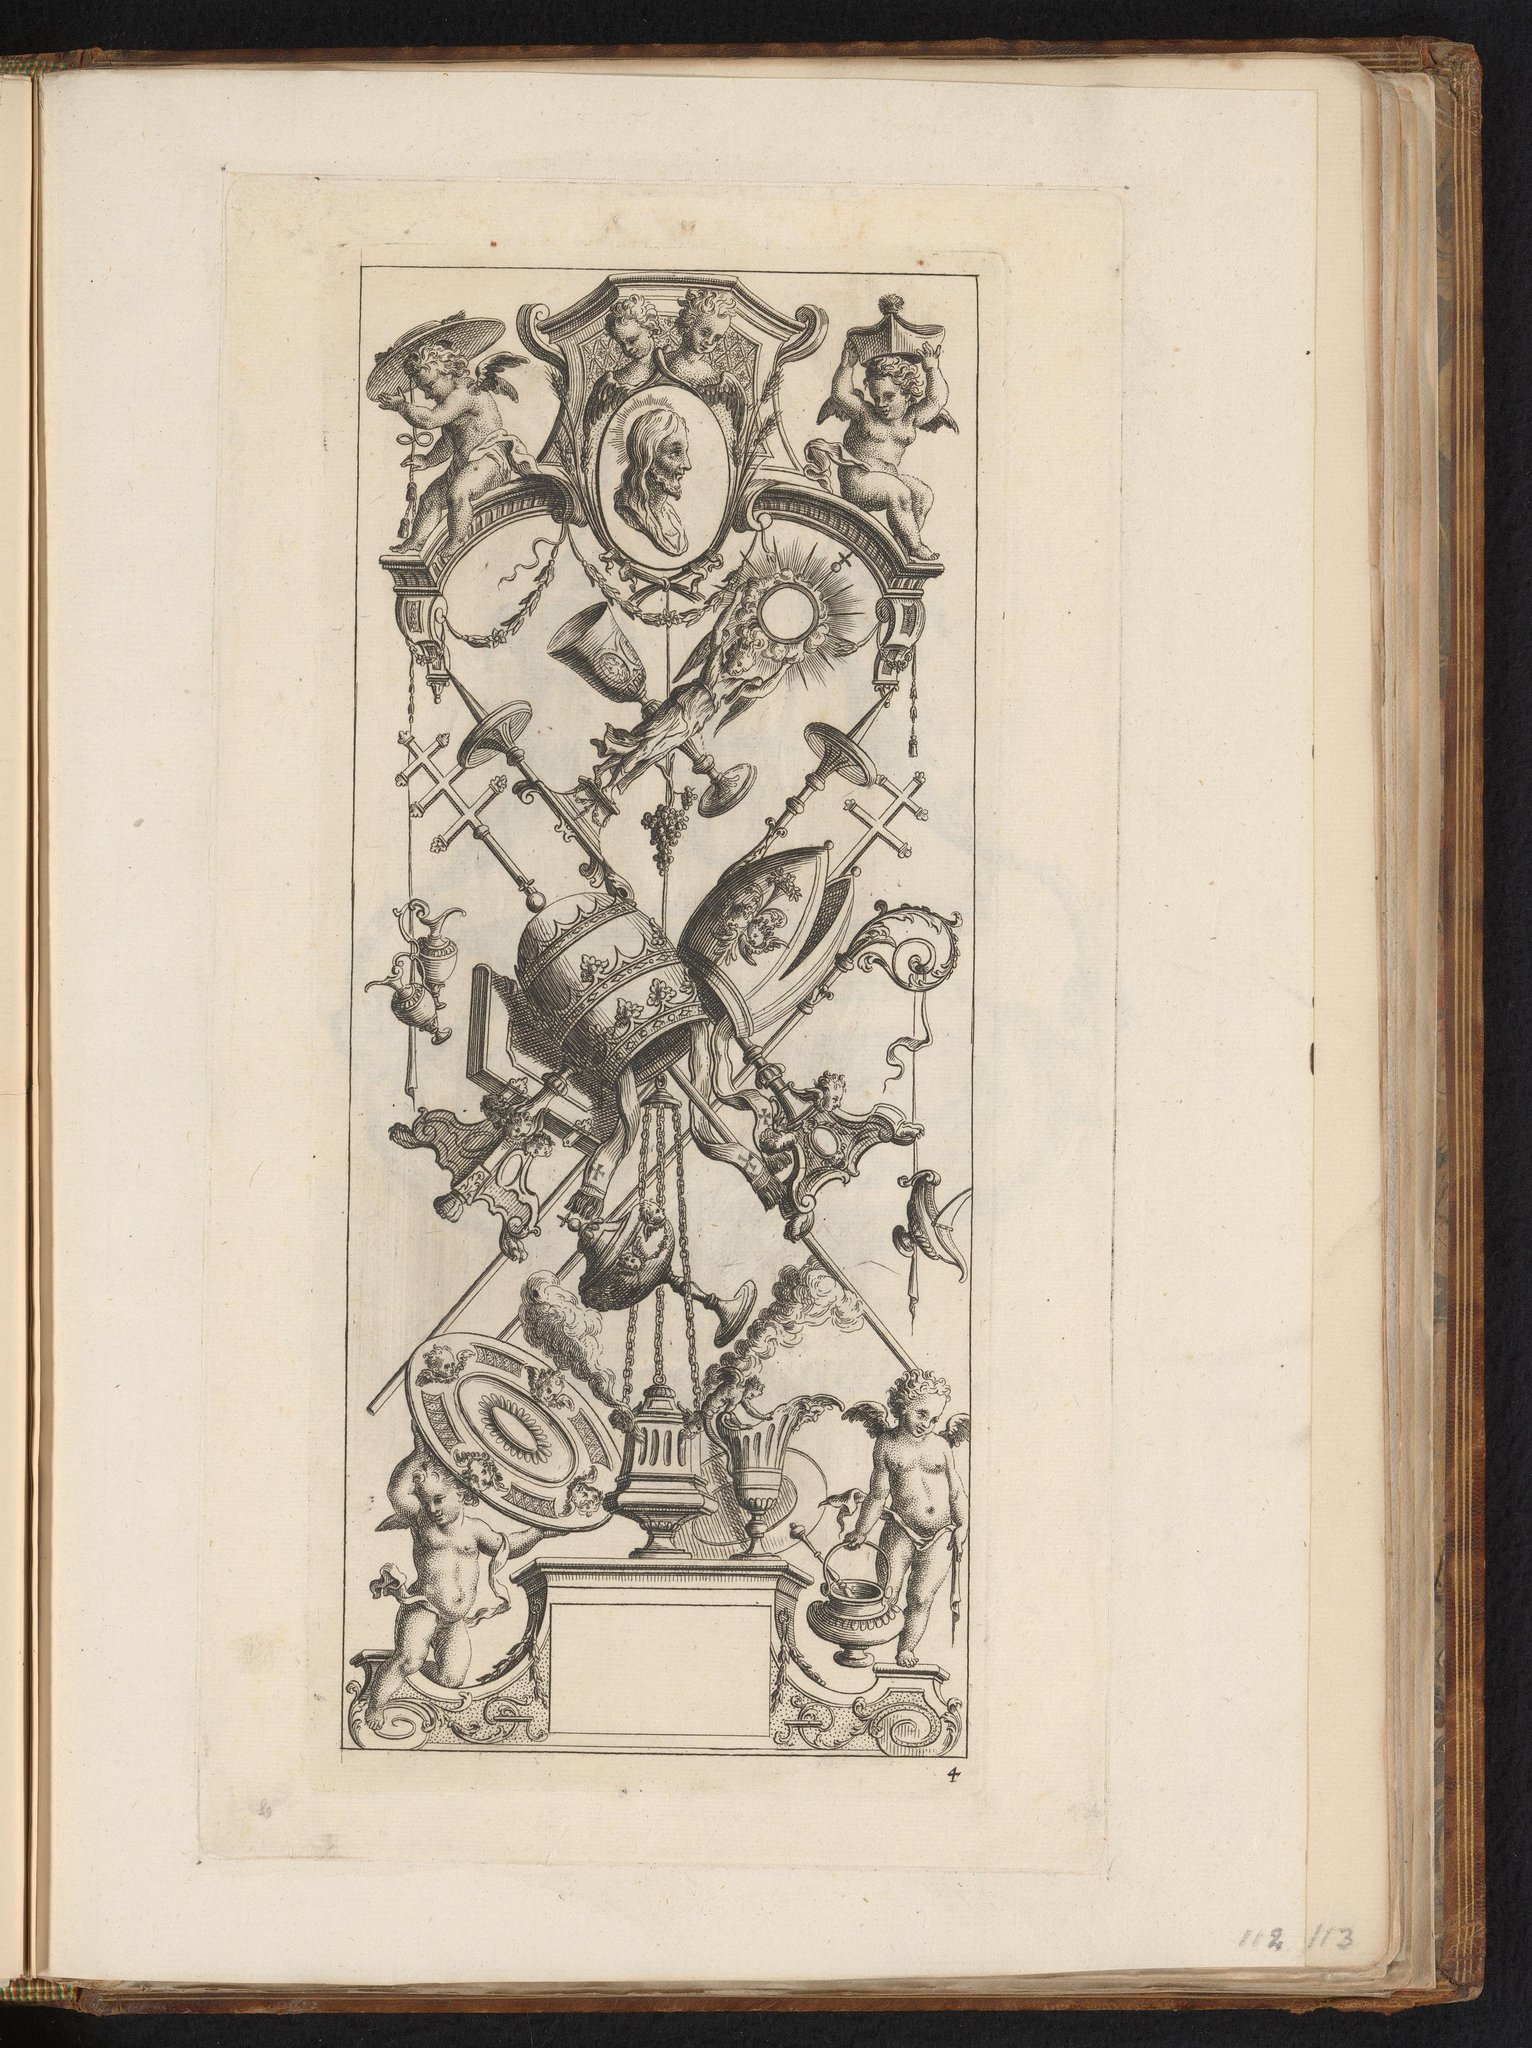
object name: album leaf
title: Livre pour Vaisselle d'Eglise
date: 1700-1735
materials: paper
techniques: etching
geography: nuremberg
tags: (liturgical) equipment of church, trophy, i.e.: decorative arrangement of symbolic or typical objects ~ ornament, ostensorium, monstrance, insignia of bishop, e.g. mitre, crozier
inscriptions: collector's mark: Lugt 2228, collector's mark: Lugt 2760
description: Kopie in spiegelbeeld naar de serie "Livre pour Vaisselle d'Eglise" uitgegeven door Balthazar Pavillon.